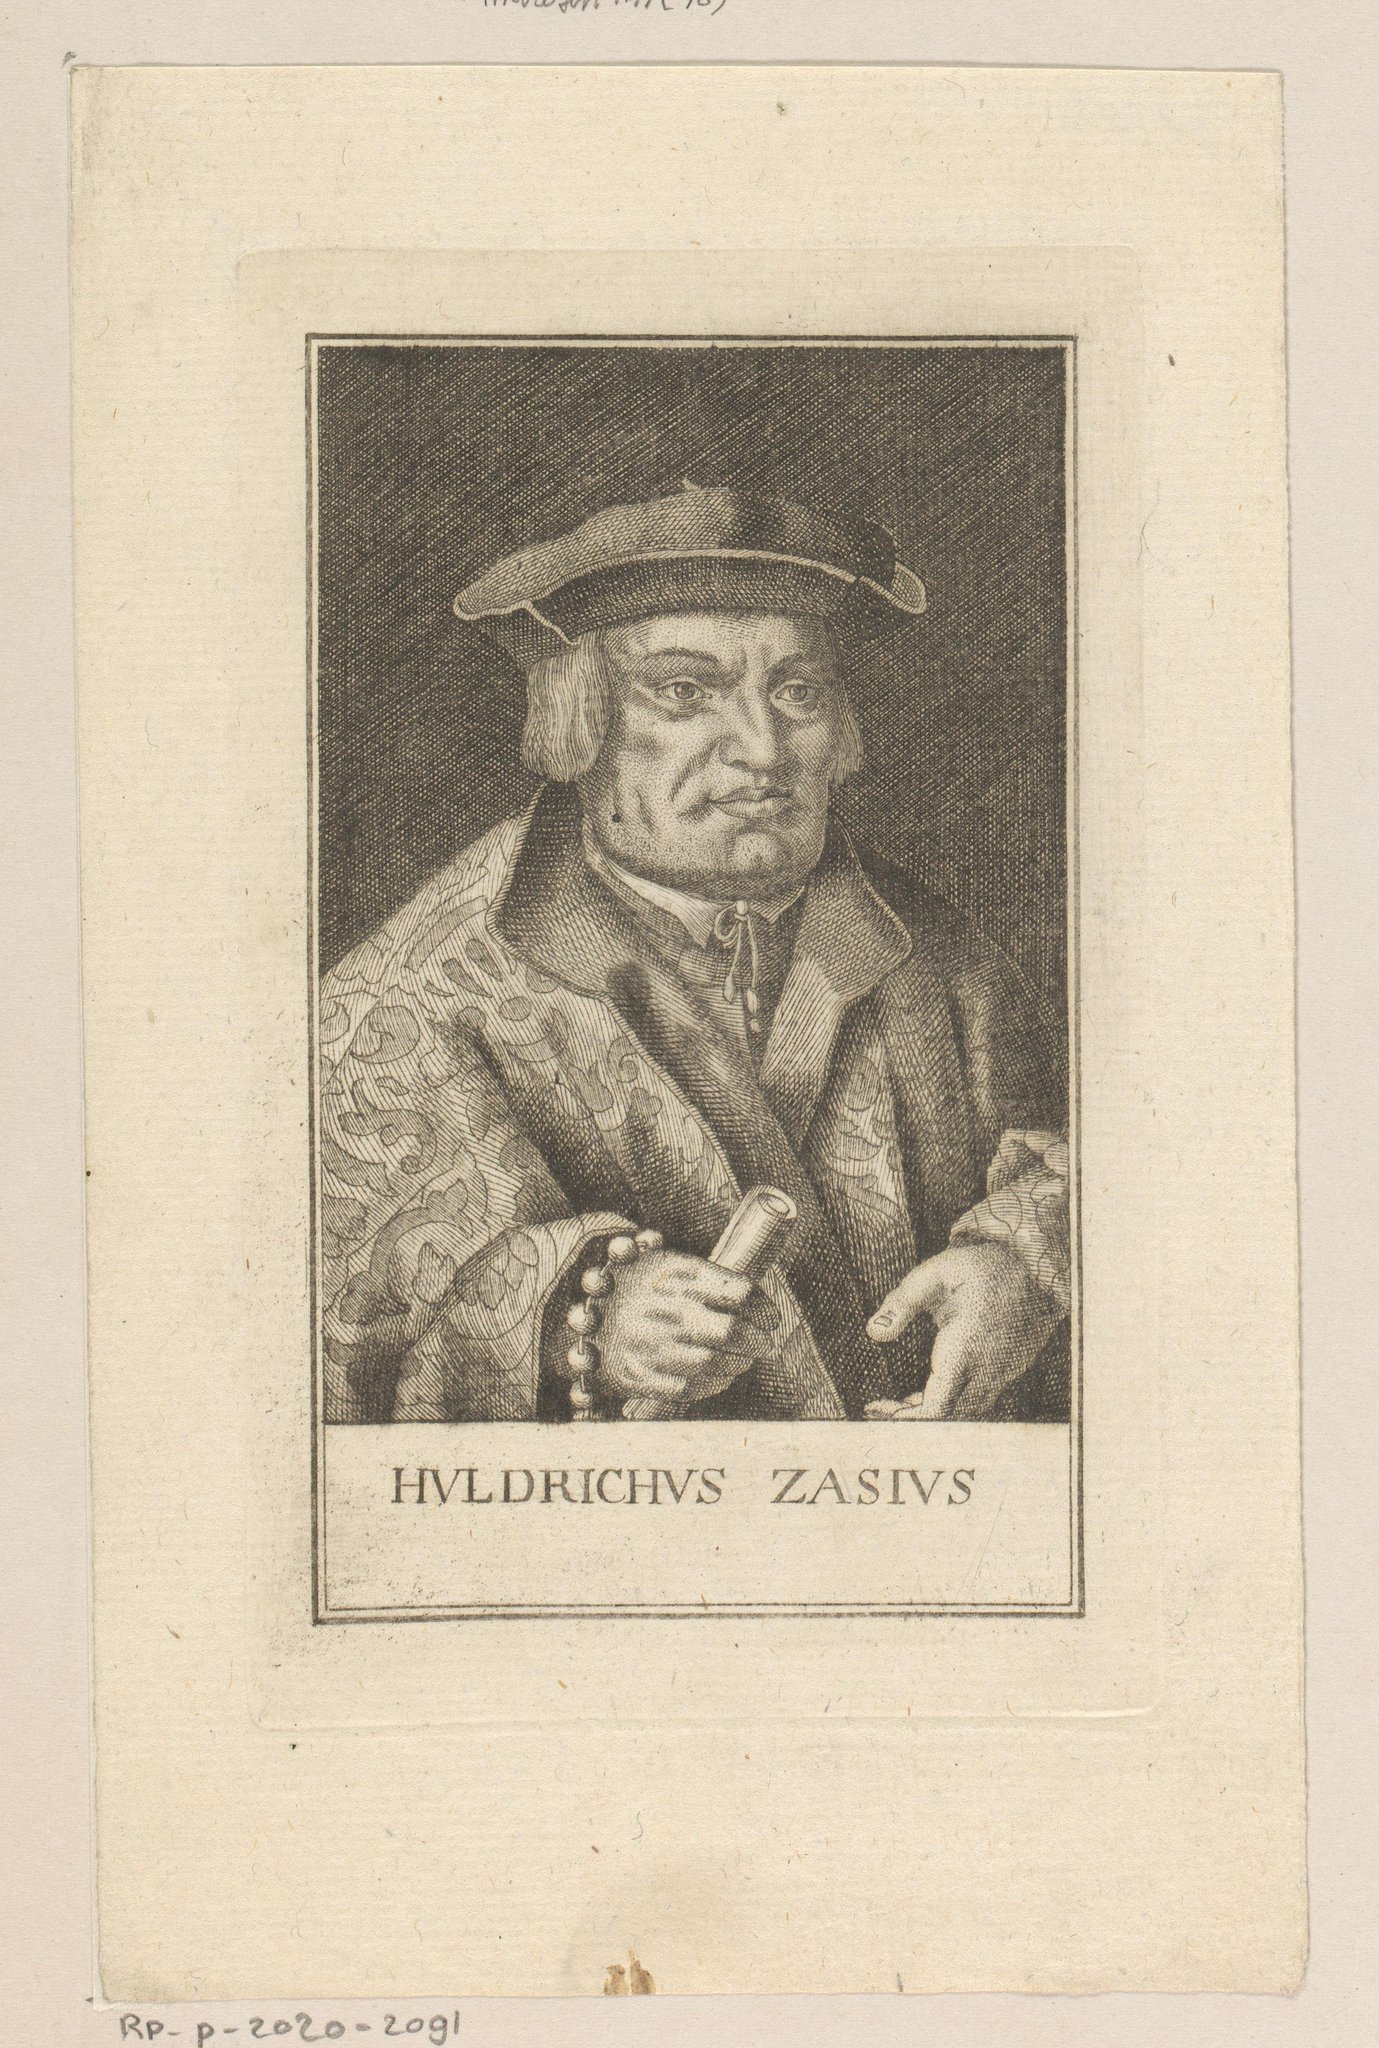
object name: print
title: Huldrichus Zasius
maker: Anonymous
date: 1700-1749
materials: paper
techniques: engraving, etching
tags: historical persons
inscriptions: collector's mark: Lugt 2228